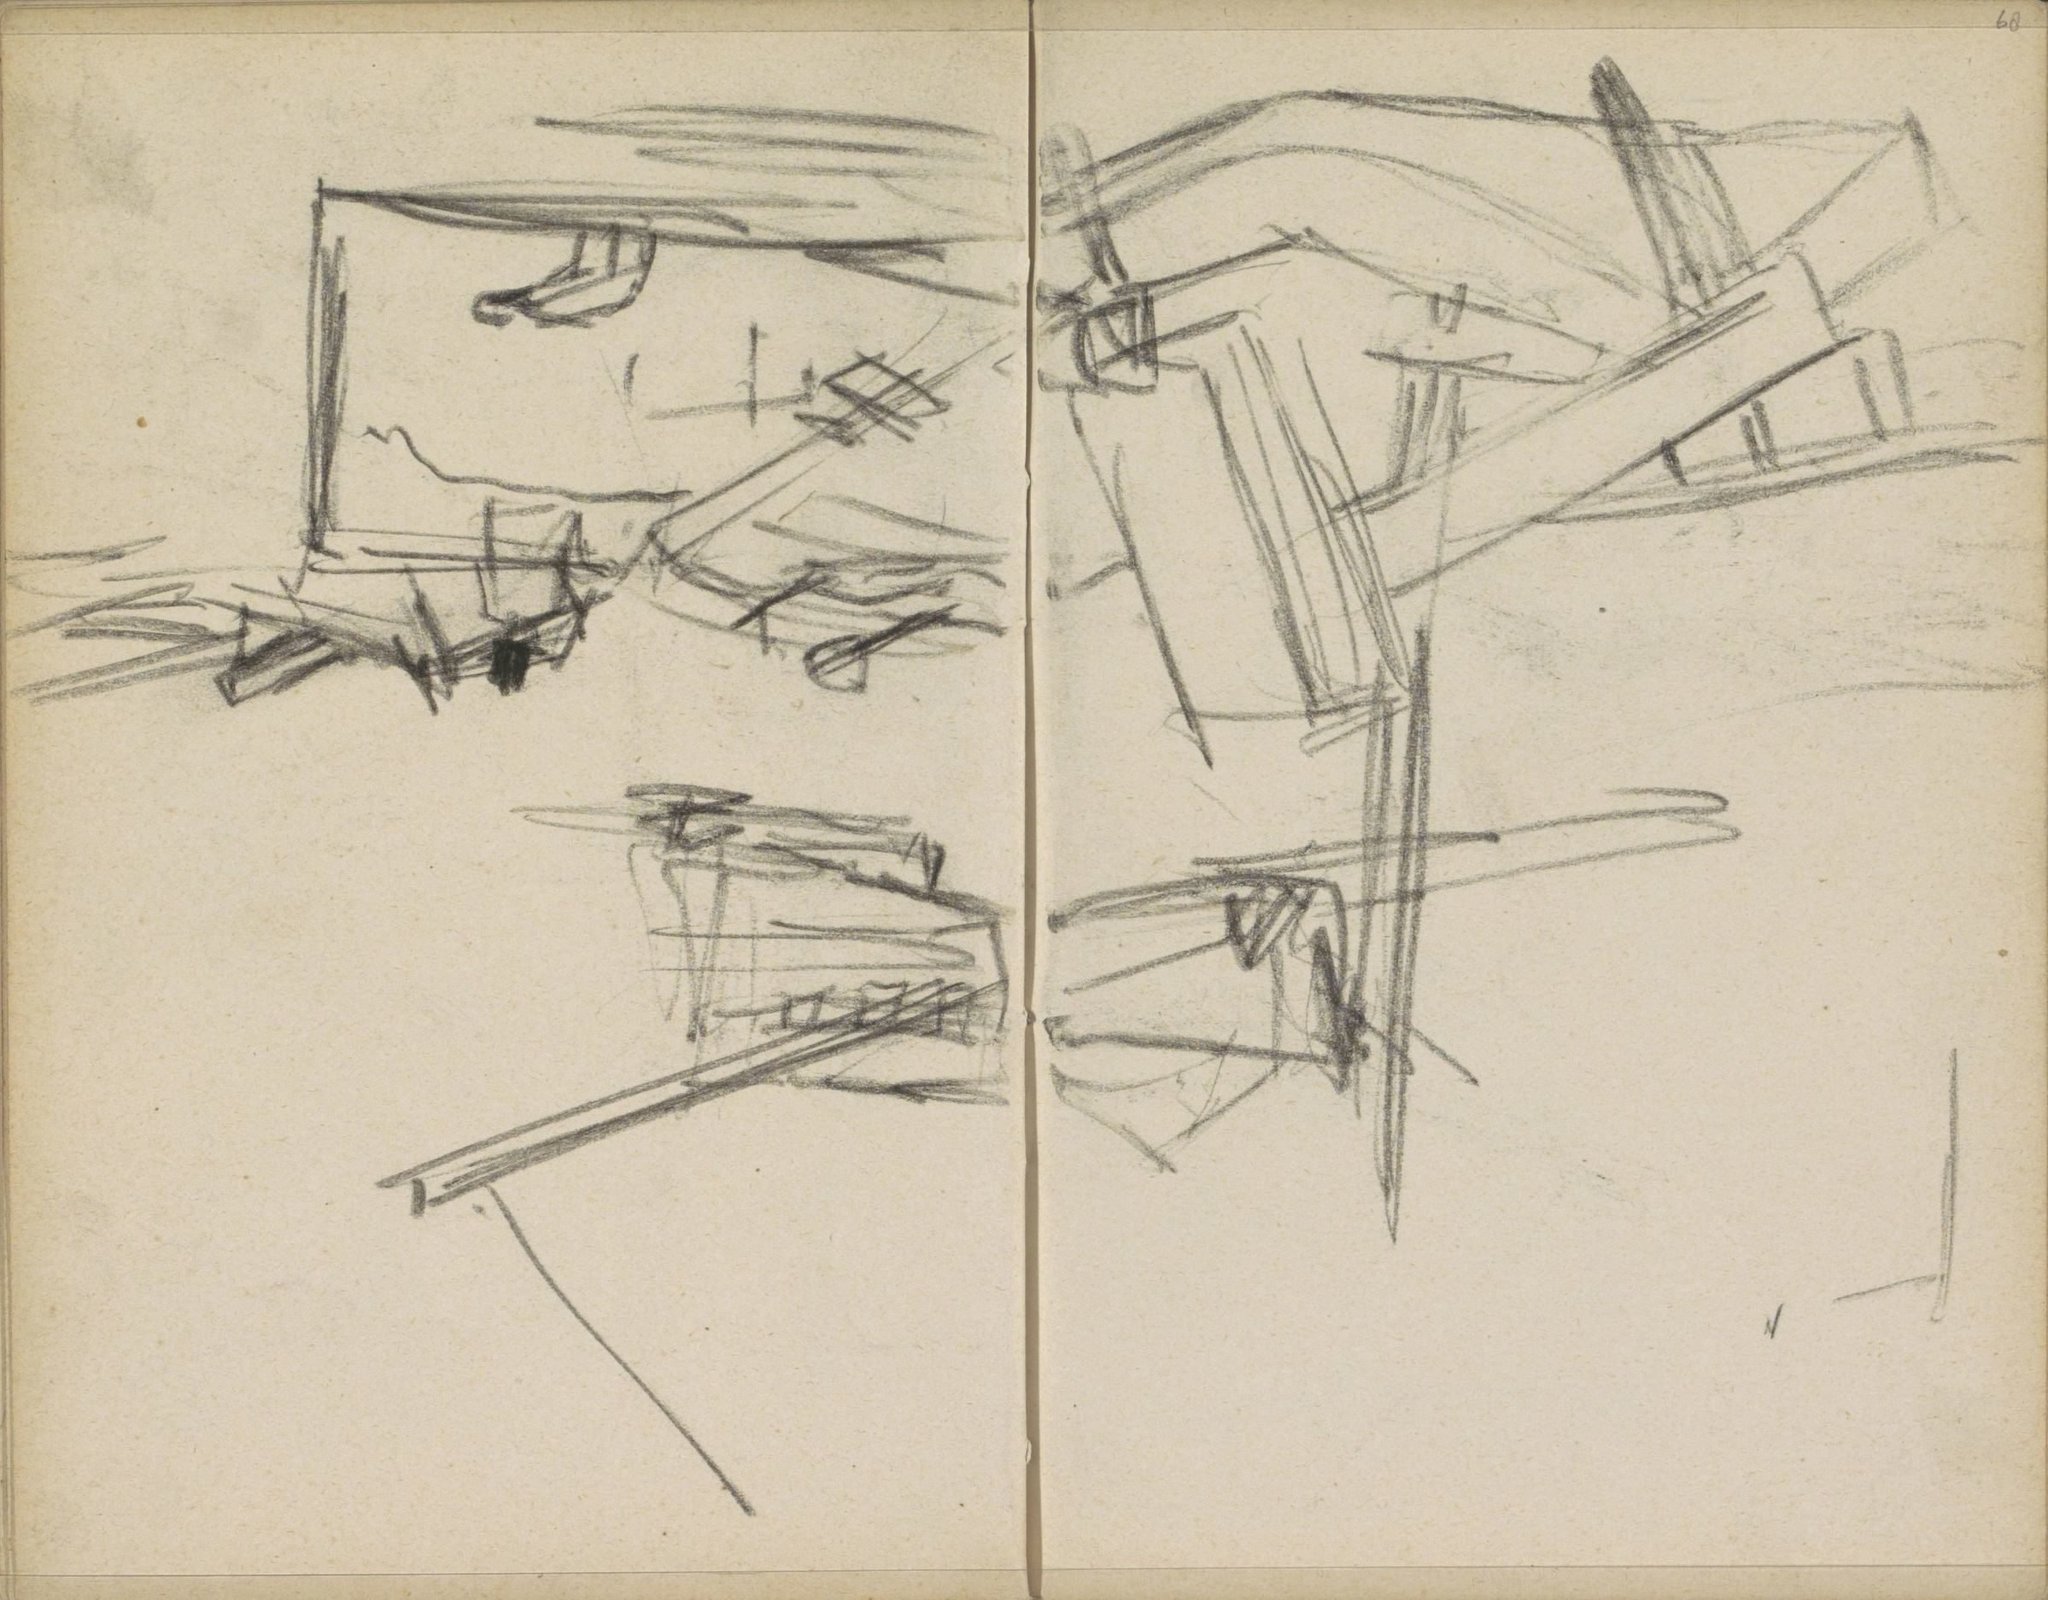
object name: sketchbook leaf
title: Studie, mogelijk van een bouwplaats of een scheepswerf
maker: george hendrik breitner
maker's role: draughtsman, painter, print maker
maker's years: 1857-1923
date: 1886-1908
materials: chalk, paper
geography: amsterdam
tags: building materials, ships (in general), building-site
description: Pagina 67 en pagina 68 uit een schetsboek met 46 bladen vervaardigd te Amsterdam, Haarlem en Antwerpen.